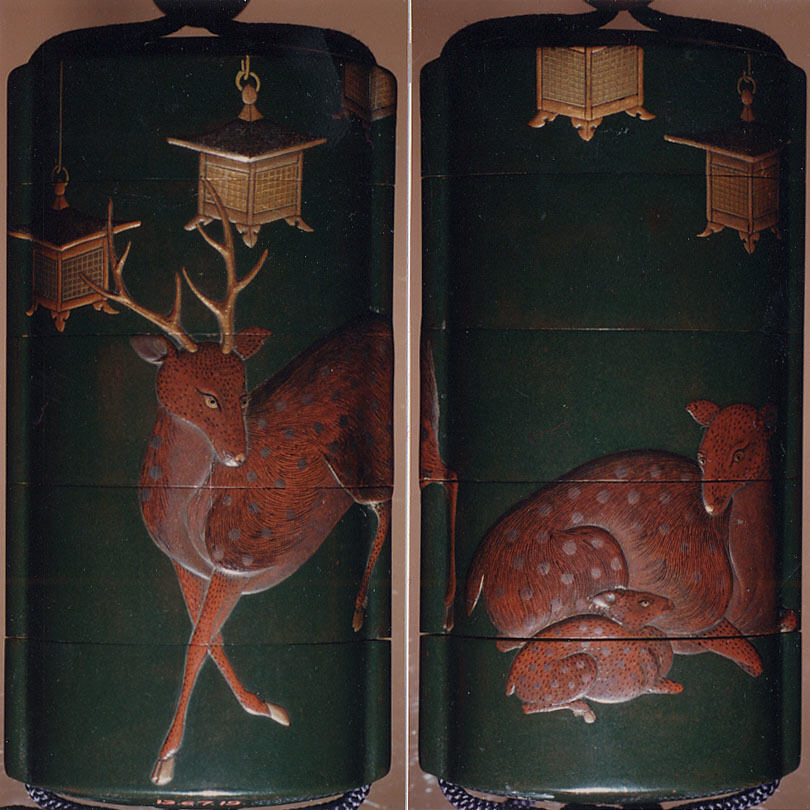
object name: inrō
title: Case (Inrō) with Design of Deer and Lanterns at Kasuga Shrine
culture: japanese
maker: yamada school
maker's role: artist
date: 1800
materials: coral, gold, lacquer, pewter, silver, wood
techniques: carving, maki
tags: deer,lanterns